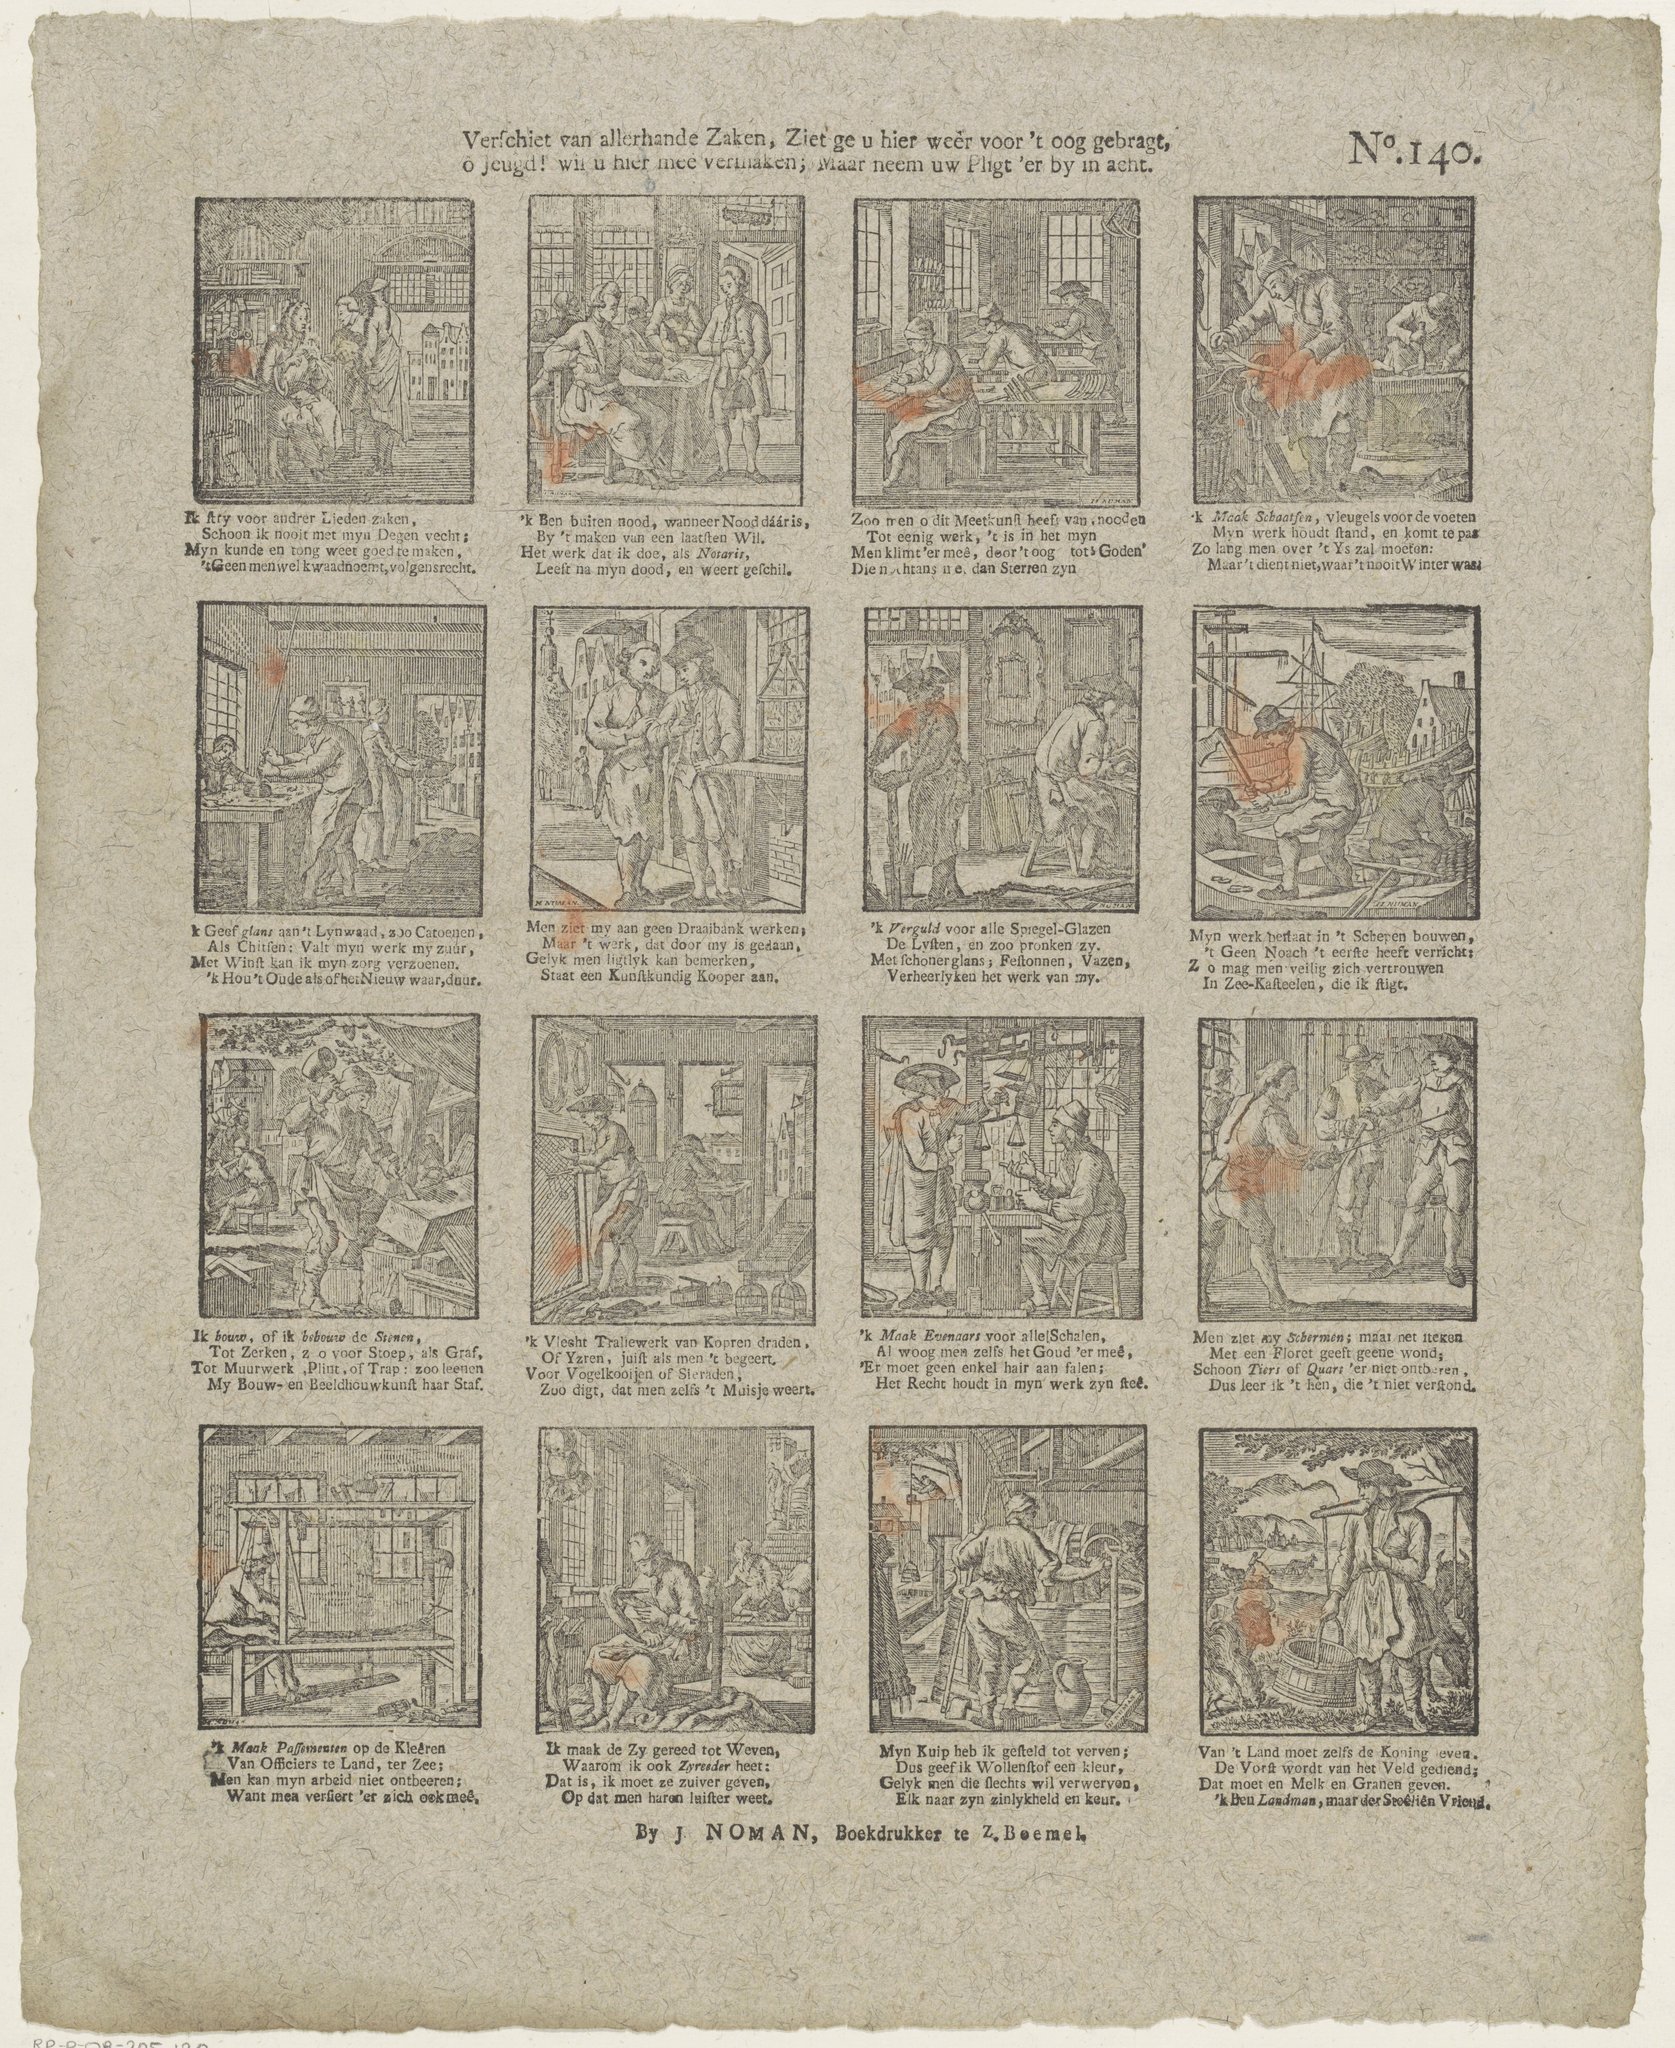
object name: print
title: Verschiet van allerhande zaken, Ziet ge u hier weêr voor 't oog gebragt, / o jeugd! wil u hier mee vermaken; maar neem uw pligt 'er by in acht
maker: johan noman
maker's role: printer, publisher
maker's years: -1833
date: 1806-1830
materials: paper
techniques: colour, letterpress printing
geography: zaltbommel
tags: craft-production, skilled handiwork, working class, labourers, notary, crafts and industries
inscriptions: collector's mark: Lugt 2760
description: Blad met 16 voorstellingen van ambachtslieden en beroepen, zoals notaris, schaatsenmaker en steenhouwer. Onder elke afbeelding een vierregelig vers. Genummerd rechtsboven: No. 140.